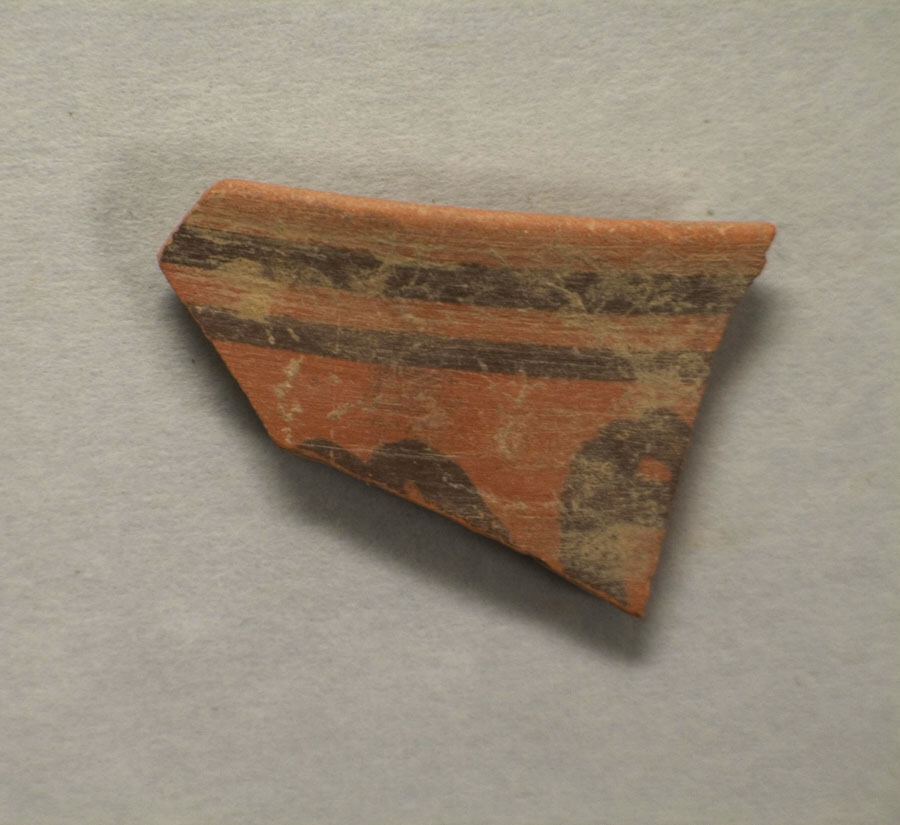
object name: shard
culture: pakistani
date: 301-500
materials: terracotta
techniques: painting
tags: gandhara